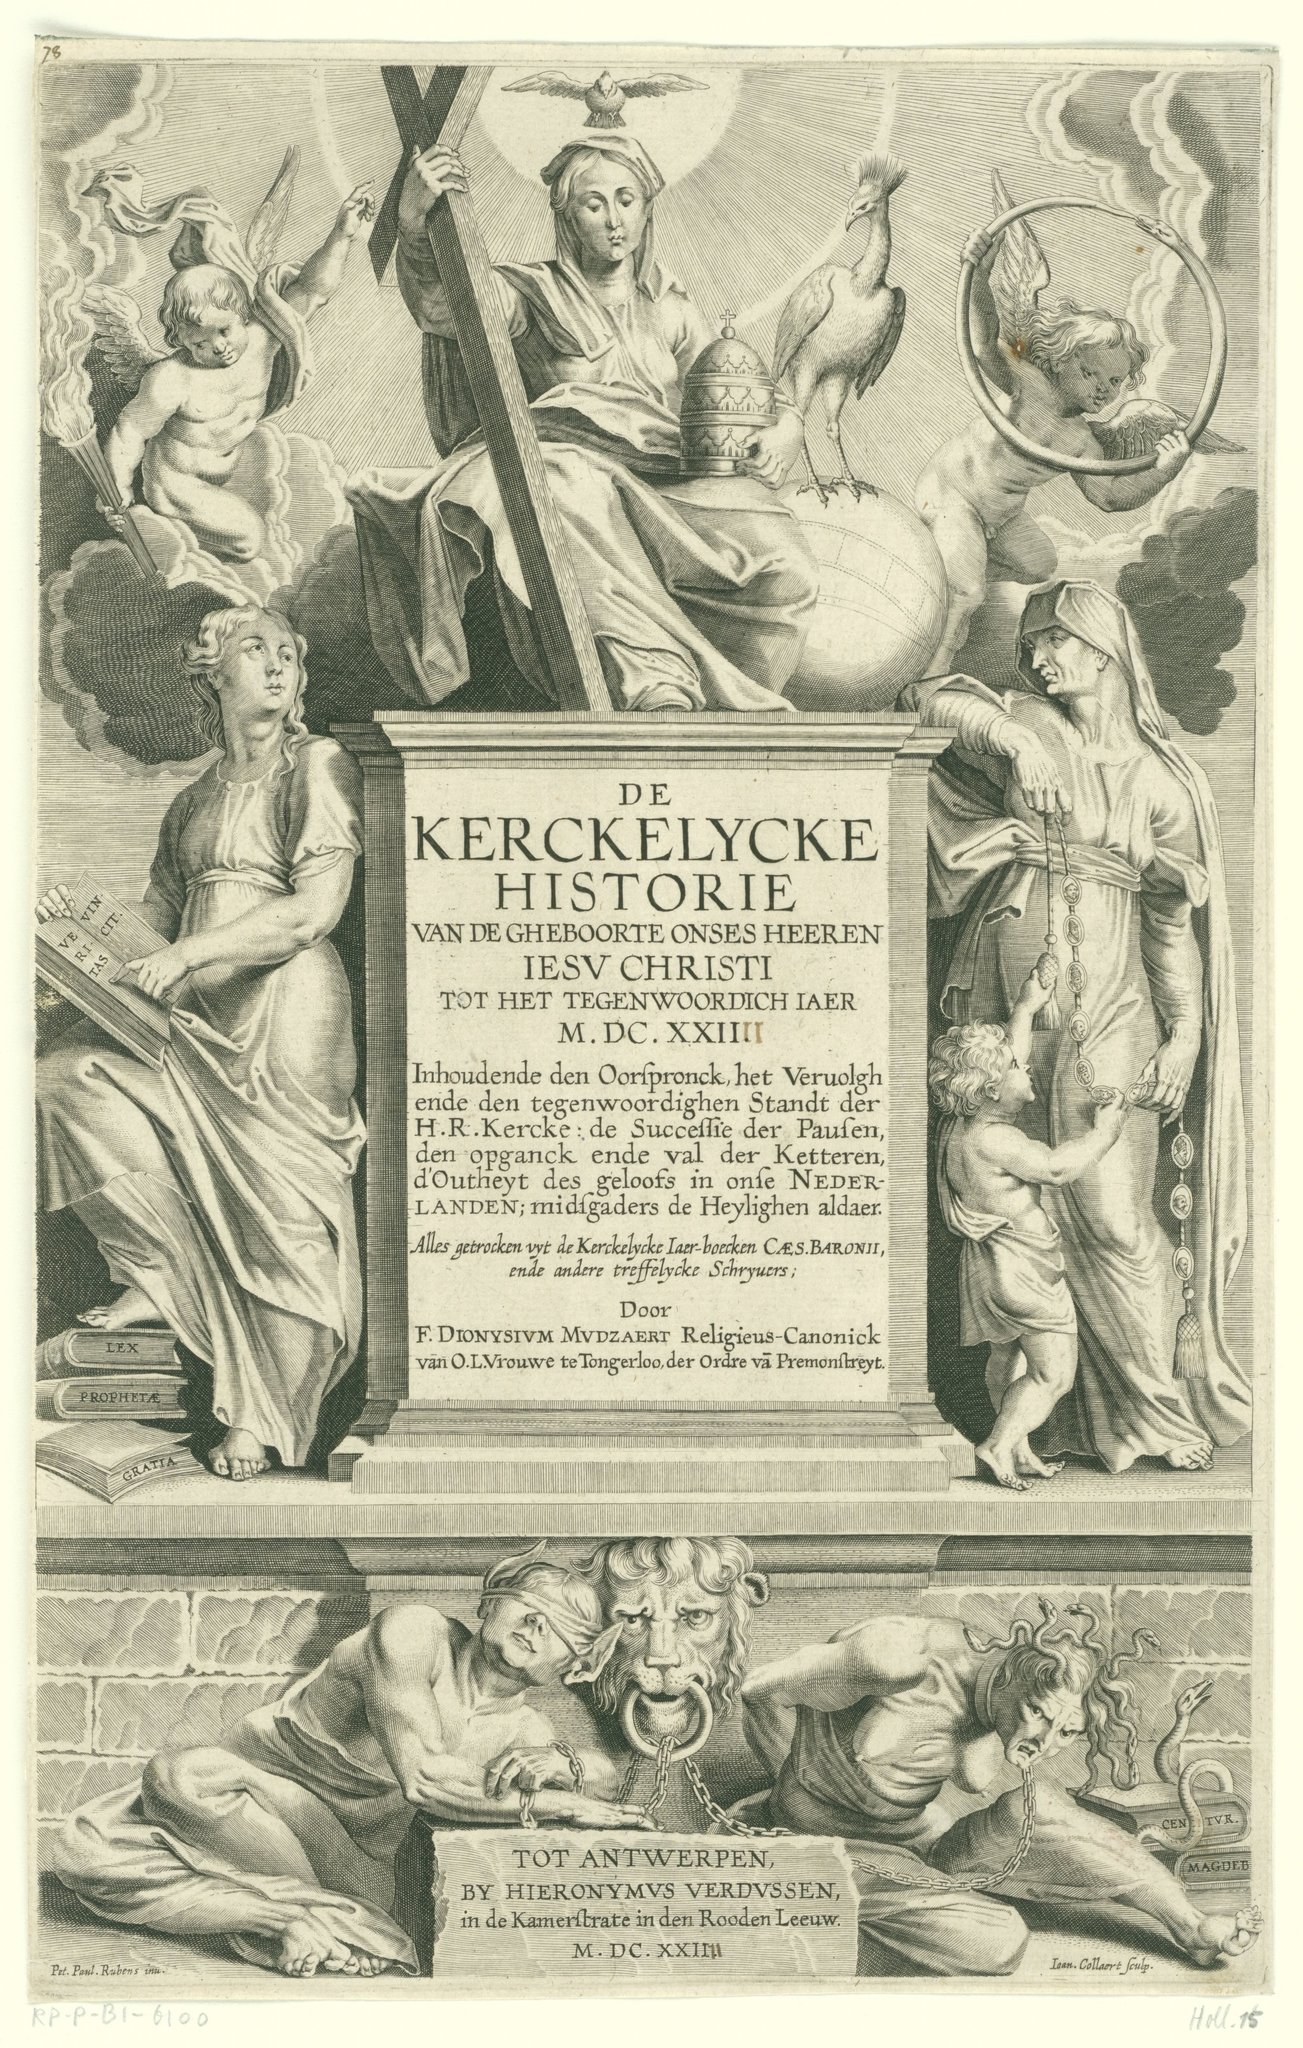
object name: print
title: Titelpagina voor: D. Mutsaerts, De Kerckelyke Historie, Antwerpen: 1622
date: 1622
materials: paper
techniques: engraving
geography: antwerp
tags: allegorical and symbolical representations ~ the church and religion, the church or christian religion vs. paganism and unbelief, heresy; 'heresia' (ripa), the true church vs. the false church, heresy or sectarianism; schism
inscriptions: signature: ‘Ioan. Collaert sculp.’, address: ‘TOT ANTWERPEN / BY HIERONYMUS VERDUSSEN, / in de Kamerstrate in den Rooden Leeuw / M.DC. XXII’, collector's mark: Lugt 240, signature: ‘Pe. Paul Rubens inv.’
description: De katholieke kerk in de persoon van een zittende vrouw met crucifix en pauselijke tiara in de handen, zit op een sokkel waarop de titel van het boek. Boven haar hoofd de Heilige Geest als duif, naast haar een phoenix (?) op de wereldbol. Links een engeltje met toorts, rechts een met de ourobouros. Naast de sokkel twee staande vrouwenfiguren. Middenonder de ketterij die aan banden is gelegd.